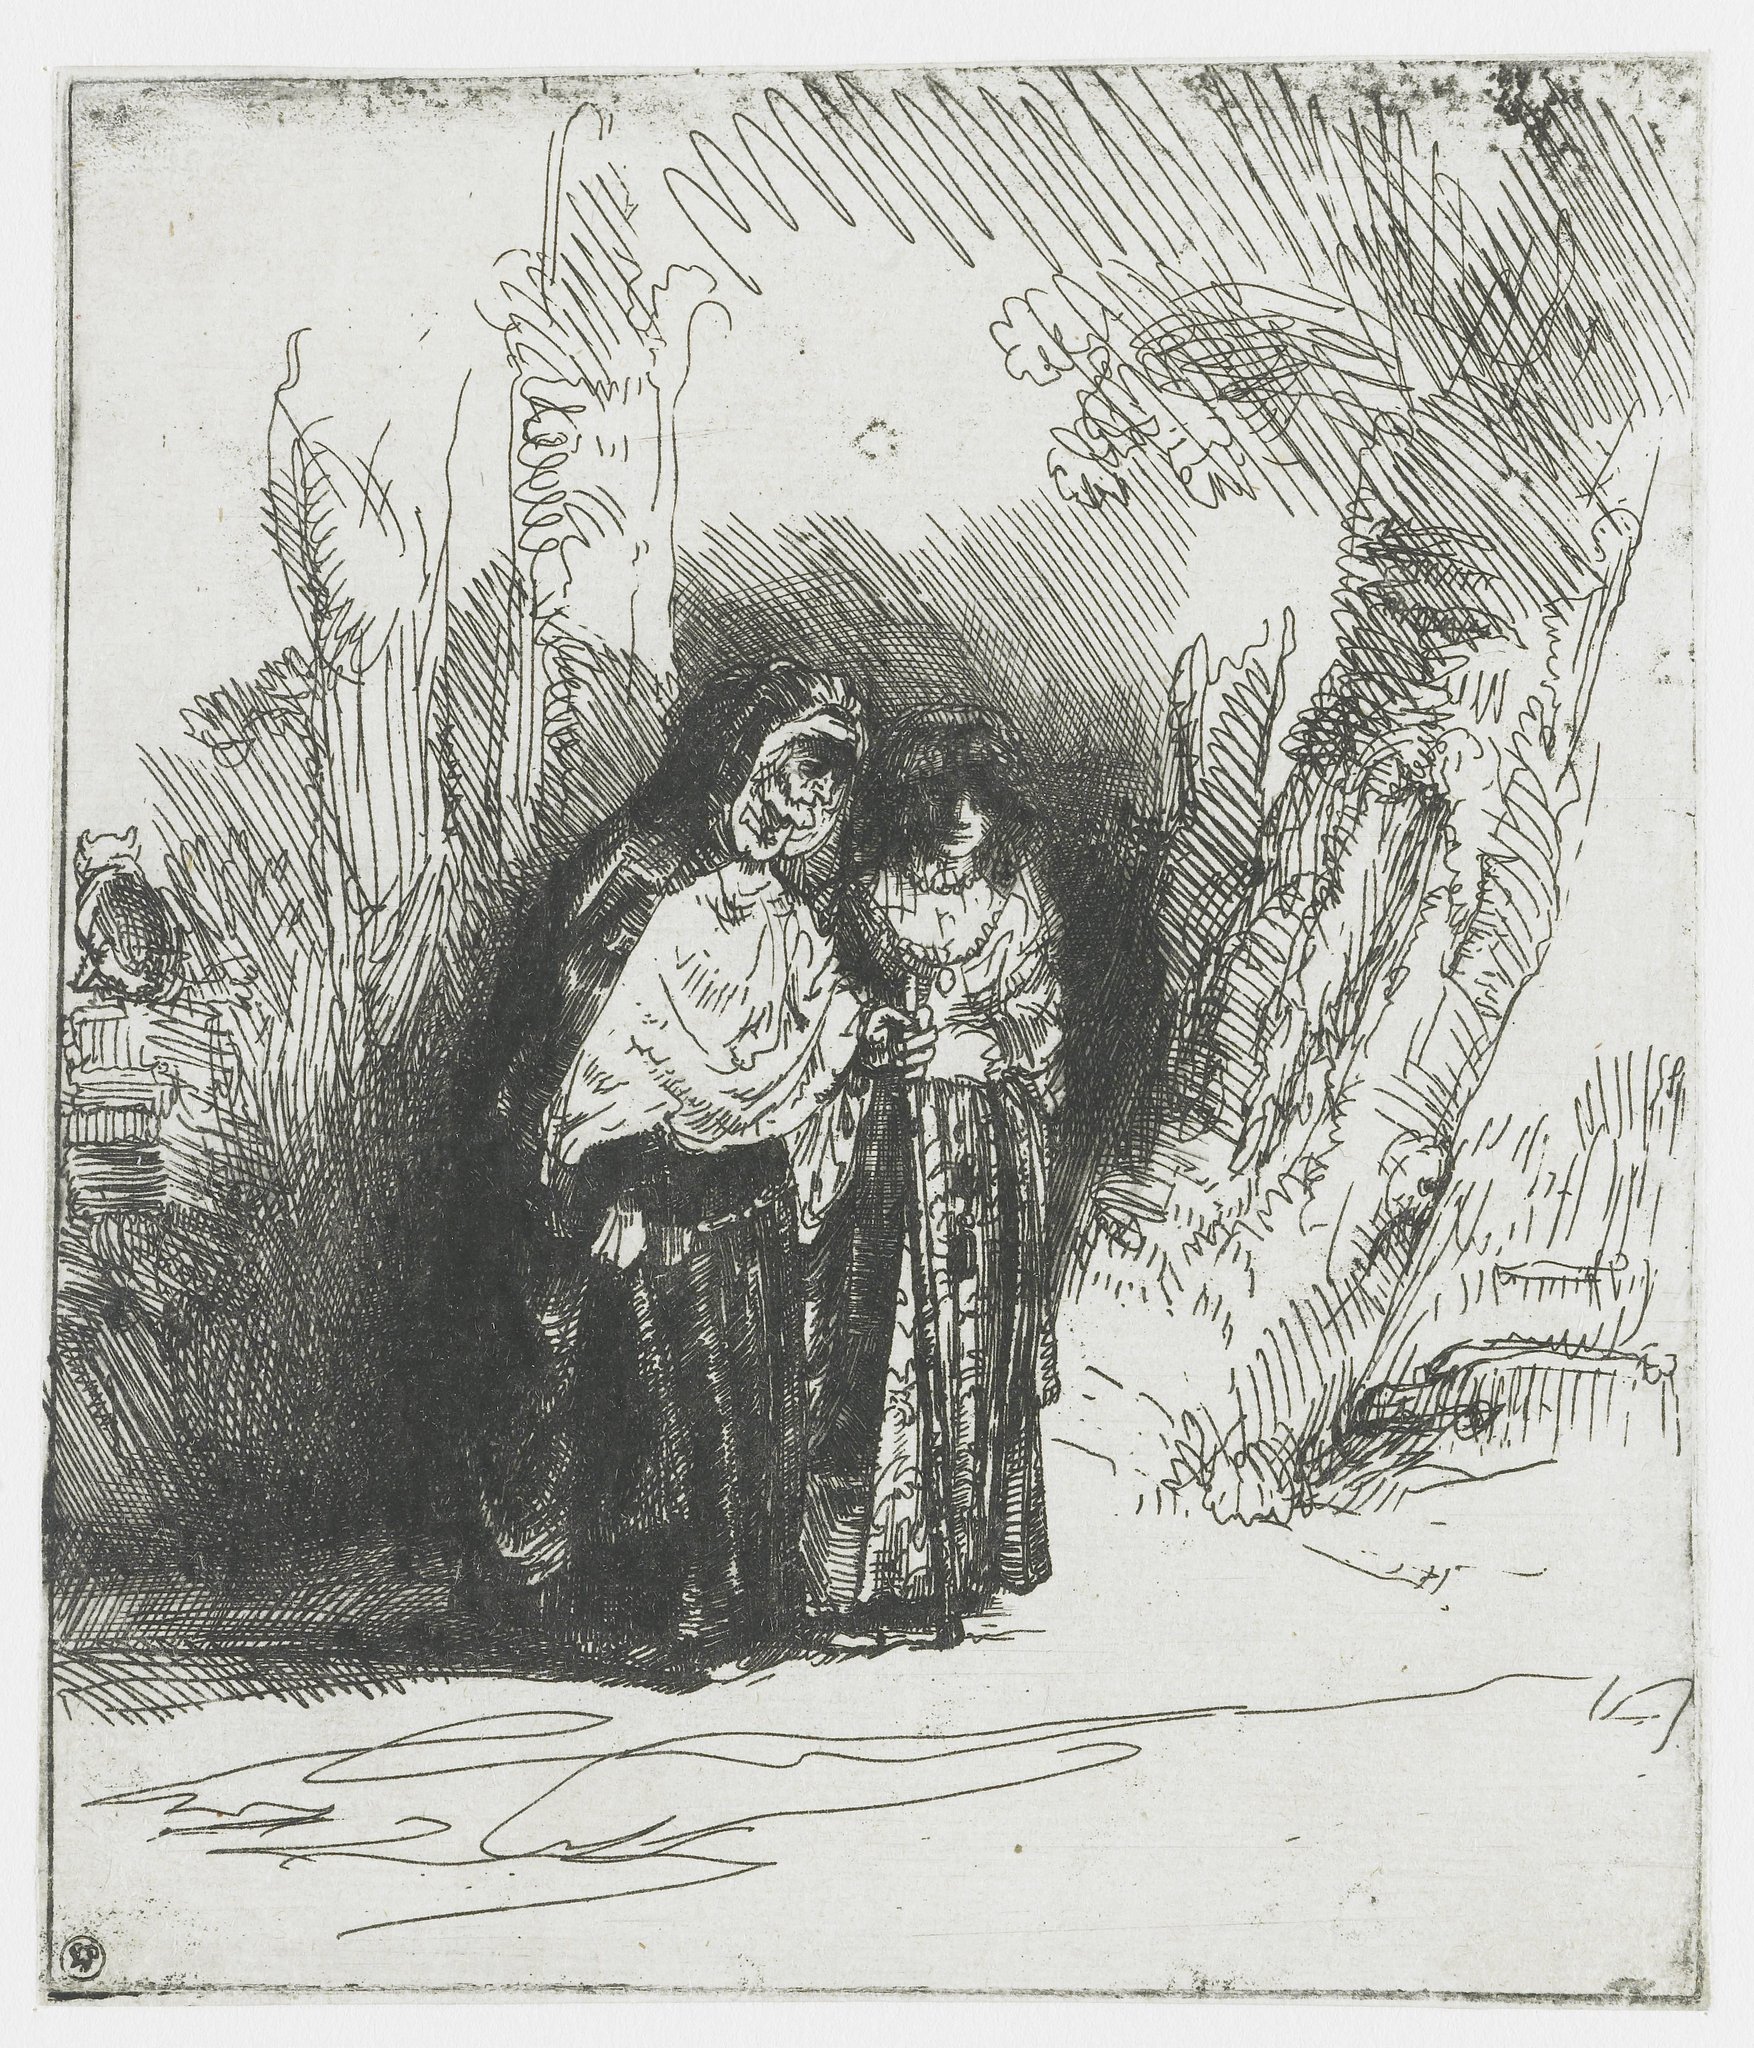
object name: print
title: The Spanish gypsy 'Preciosa'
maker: rembrandt van rijn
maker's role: draughtsman, painter, print maker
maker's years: 1606-1669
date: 1642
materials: paper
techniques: etching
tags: wandering communities: romani or roma, preciosa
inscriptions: mark: ‘symbool in een cirkel’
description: Het Spaanse heidinnetje Preciosa en de oude vrouw Majombe. Beide figuren ontleend aan het verhaal ‘La Gitanella’ van Miguel de Cervantes uit 1613, in Nederland bekend als ‘Het Spaans Heidinnetje’. Heiden en heidin waren eigentijdse benamingen voor het Roma-volk.